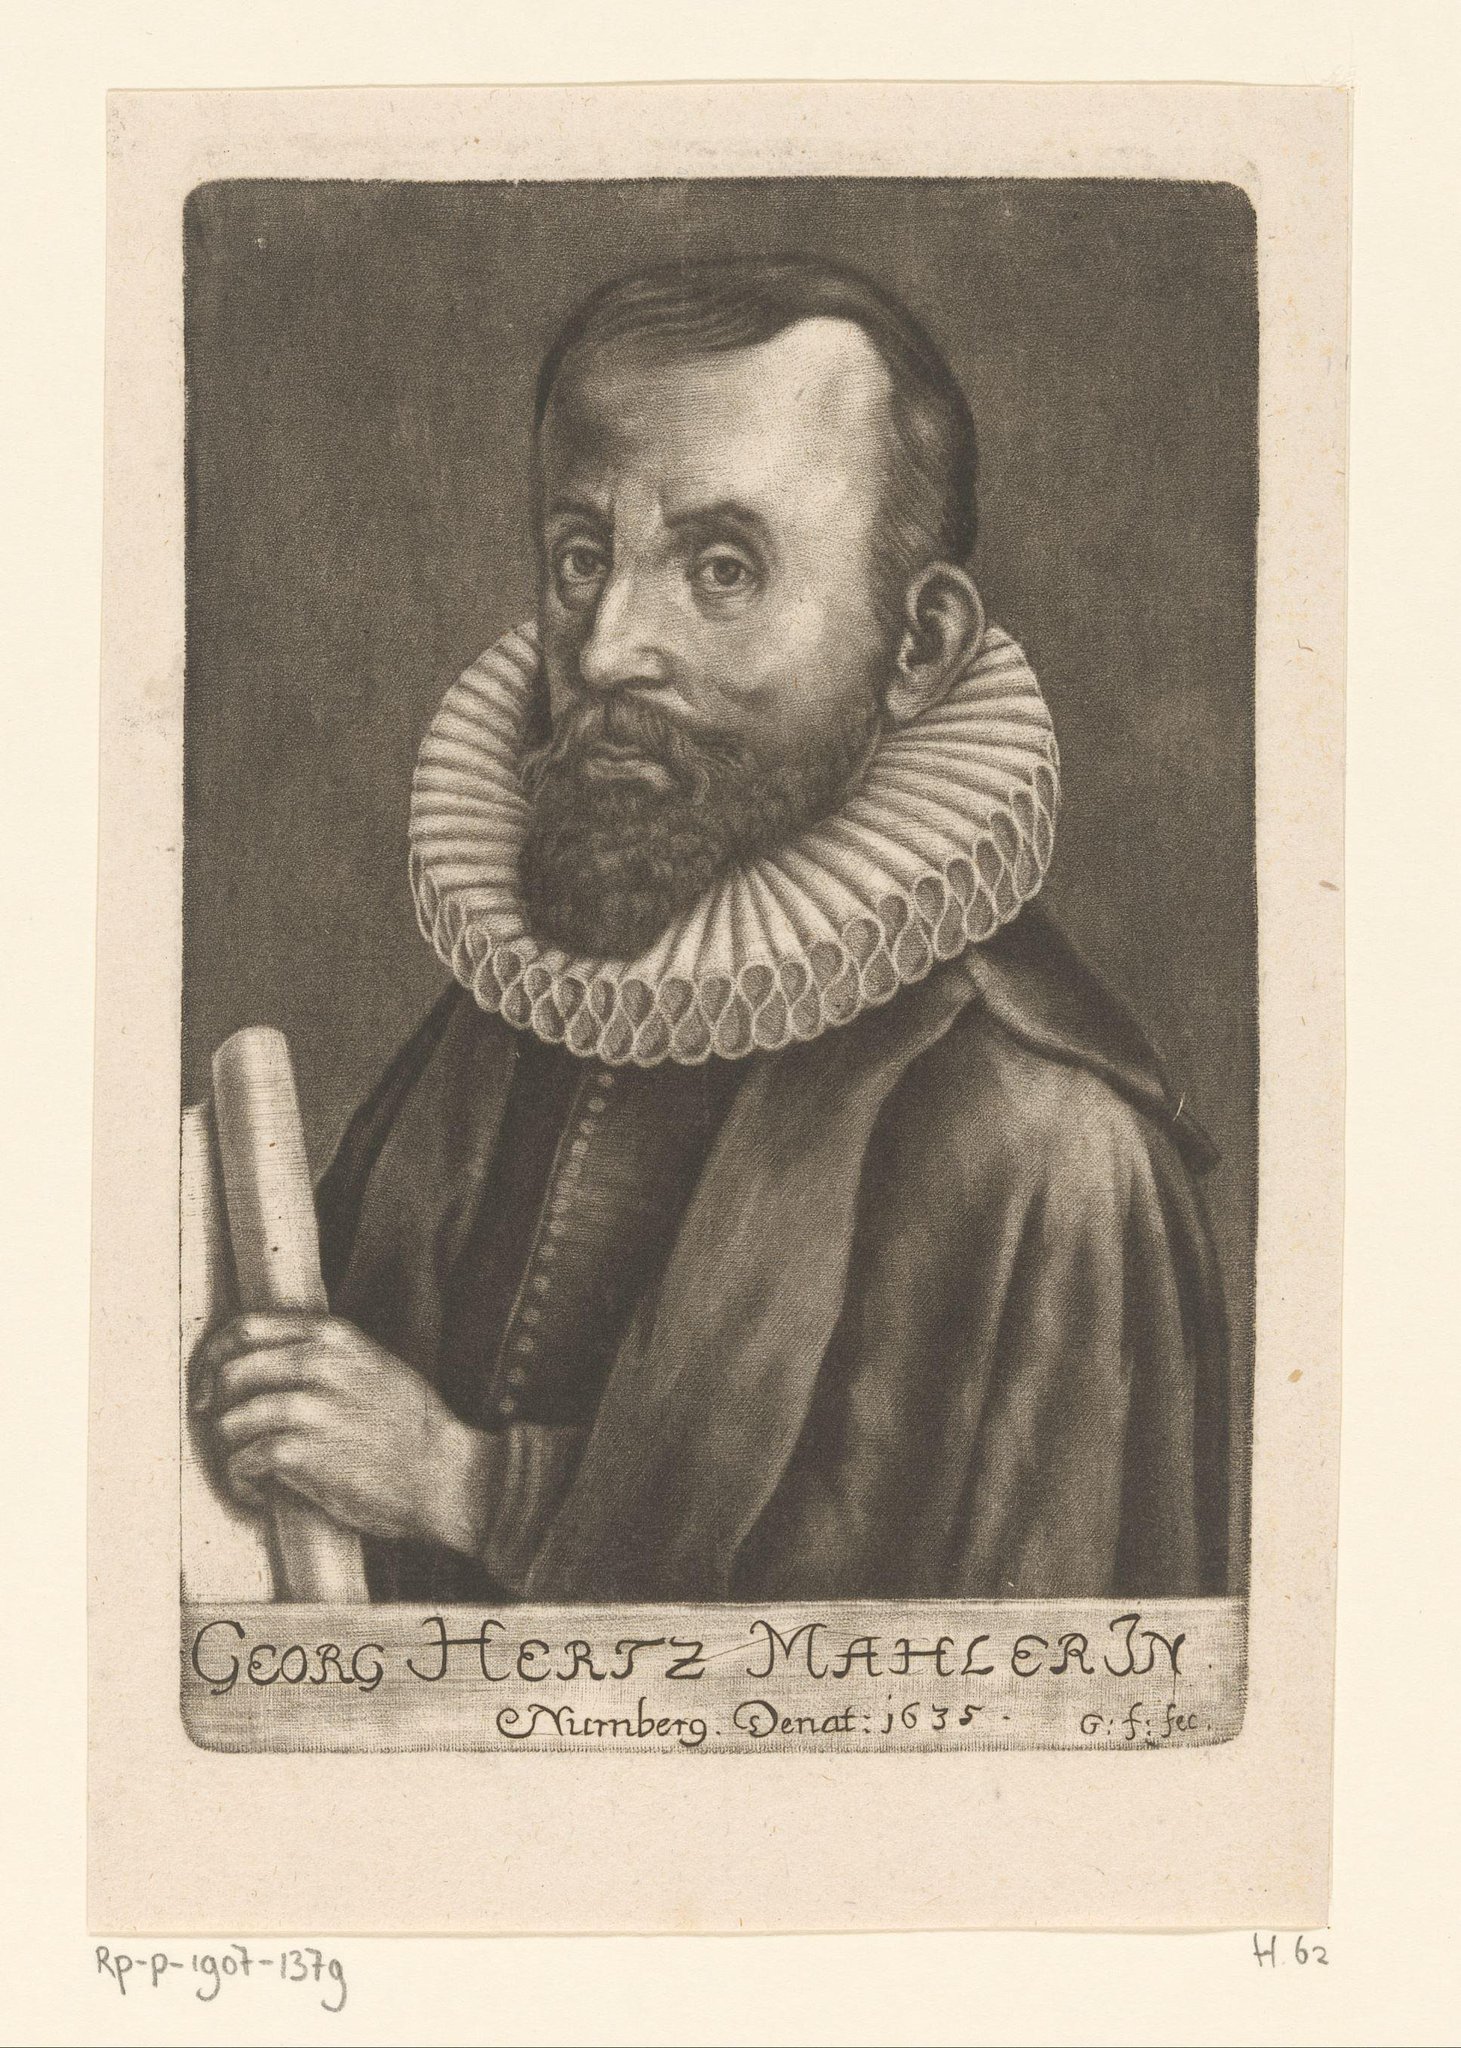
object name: print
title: Portret van Georg Hertz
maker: georg fennitzer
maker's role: print maker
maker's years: 1646-1722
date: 1656-1722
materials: paper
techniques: mezzotint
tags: painter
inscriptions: collector's mark: Lugt 2228